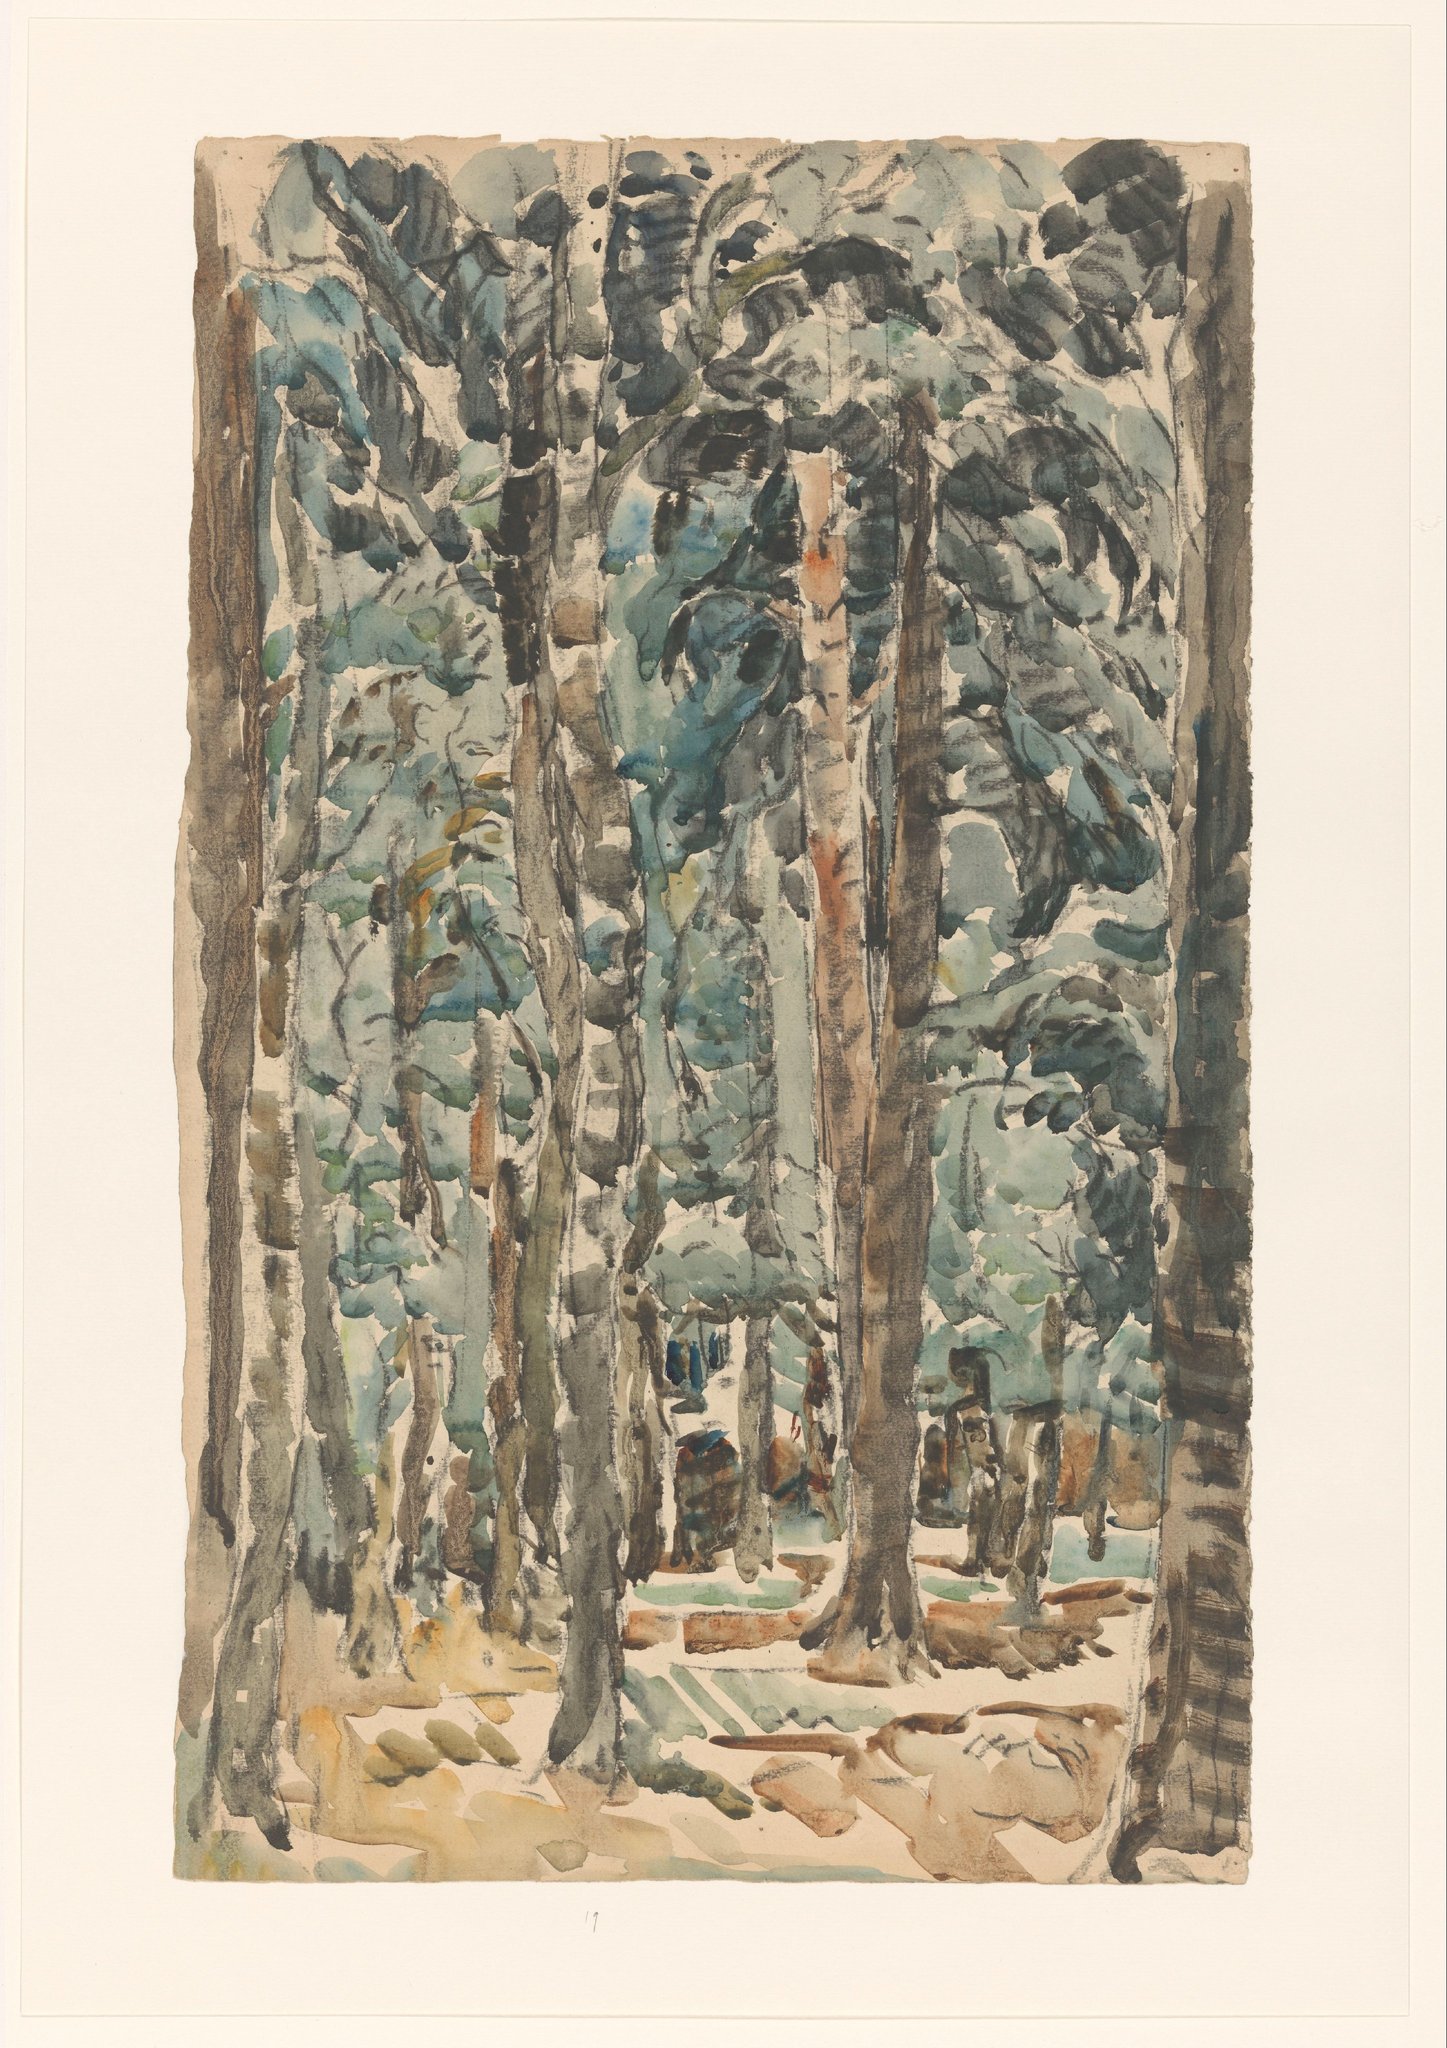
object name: watercolor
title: Bosgezicht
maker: wilhelmus johannes steenhoff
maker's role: draughtsman, print maker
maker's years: 1863-1932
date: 1873-1932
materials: chalk, paper, watercolor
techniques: brush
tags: forest, wood